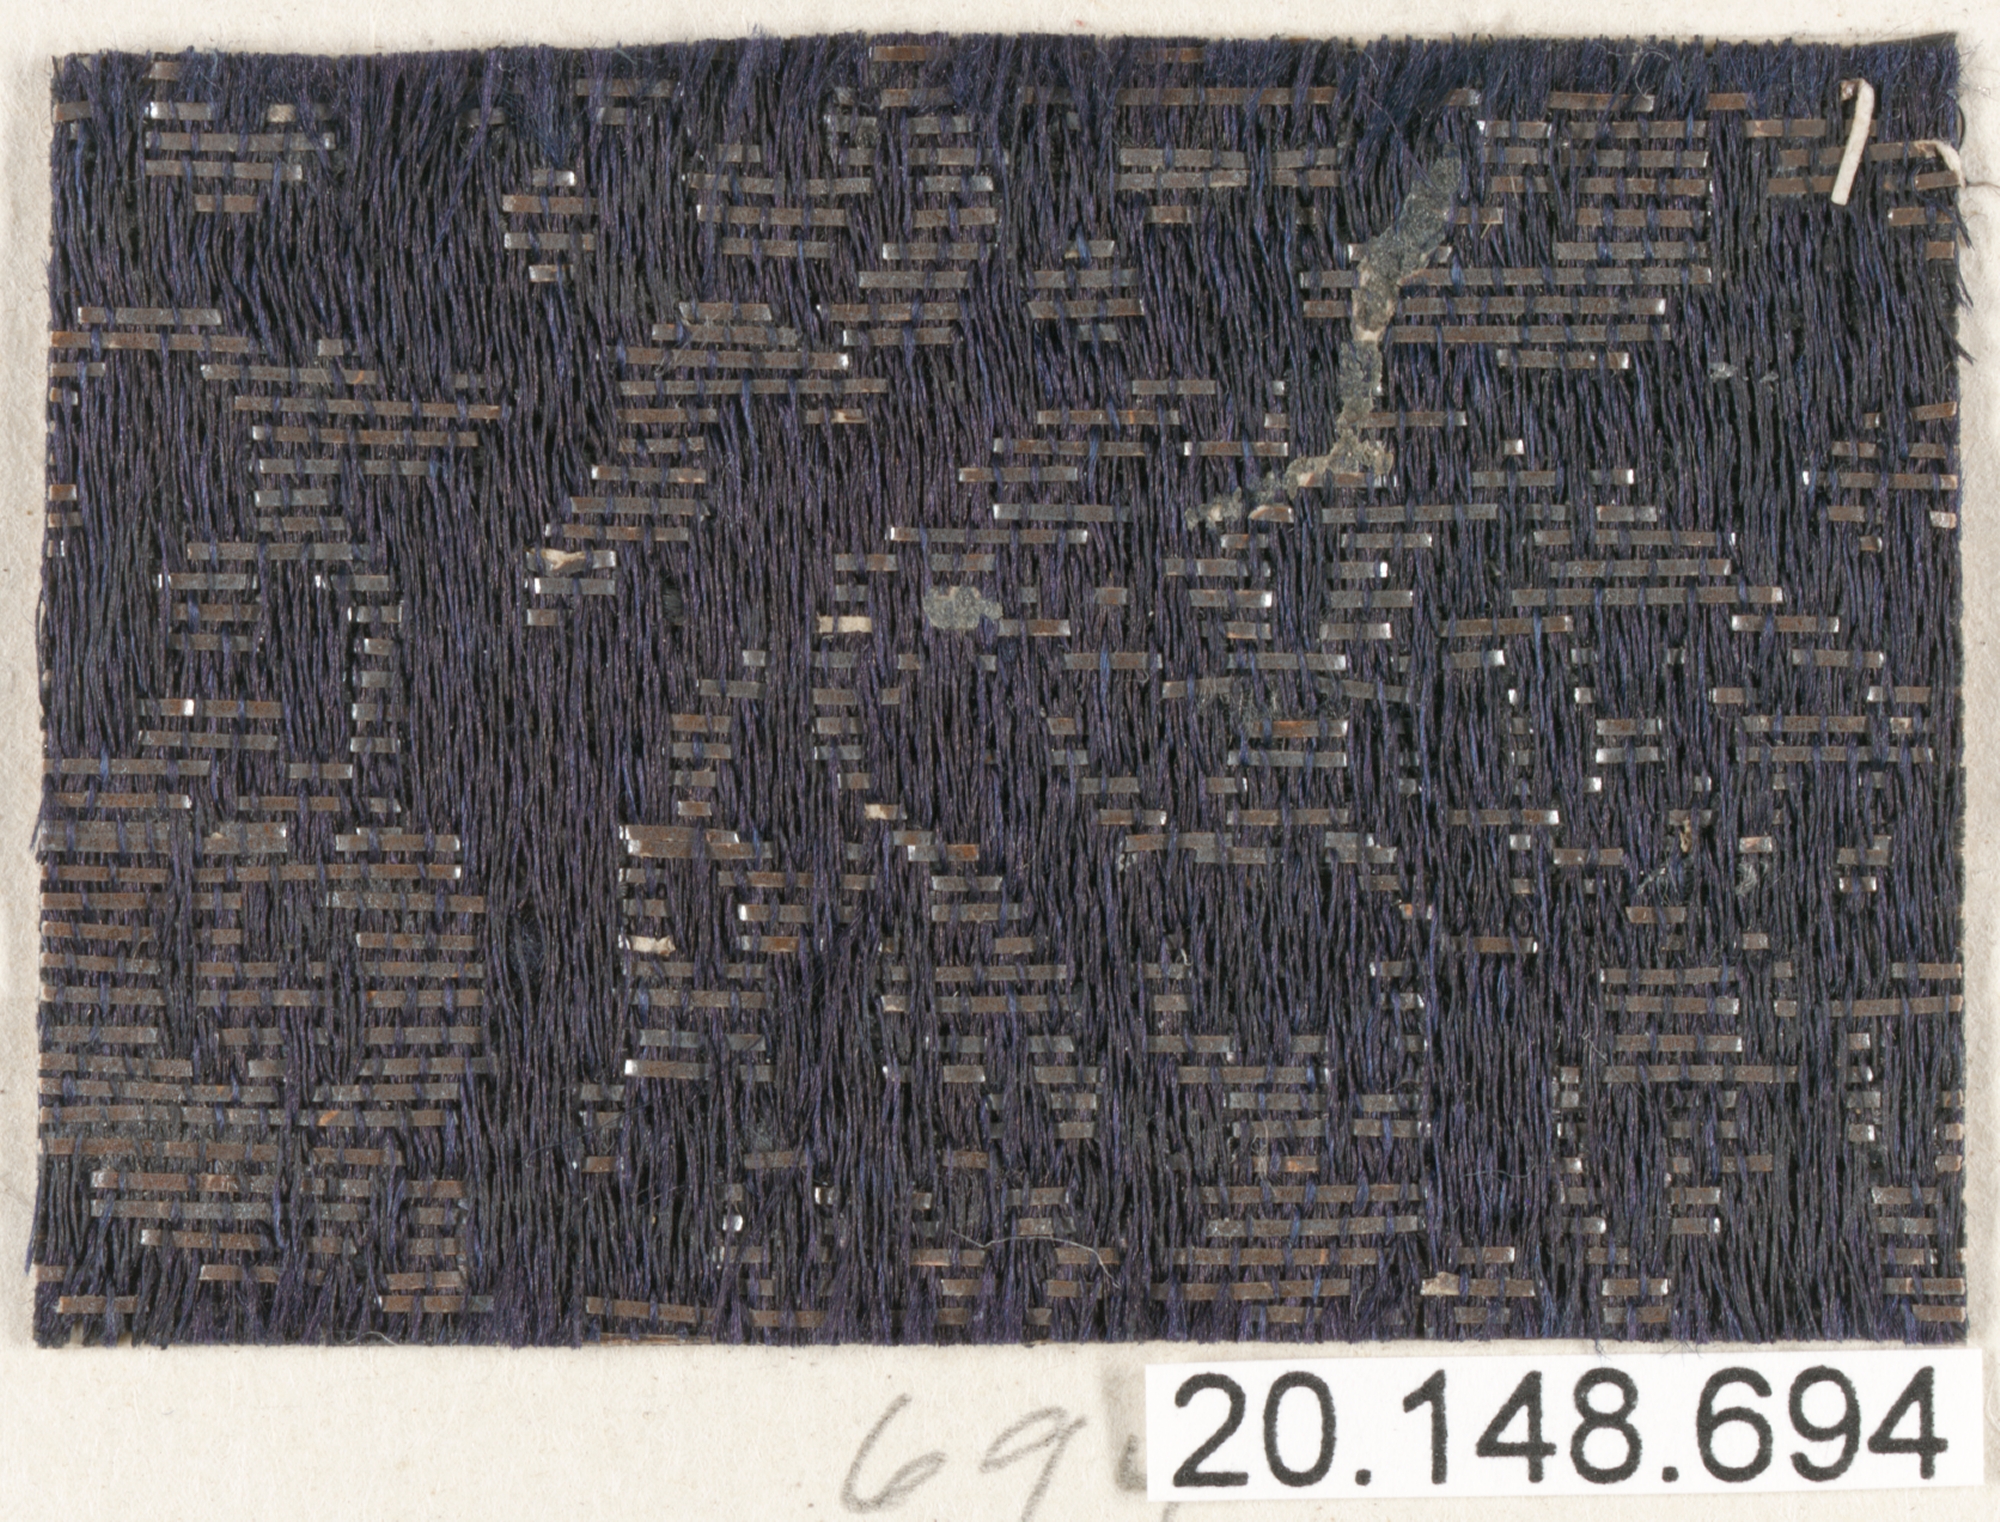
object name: piece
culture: japanese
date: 1601-1700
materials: silk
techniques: compound weave